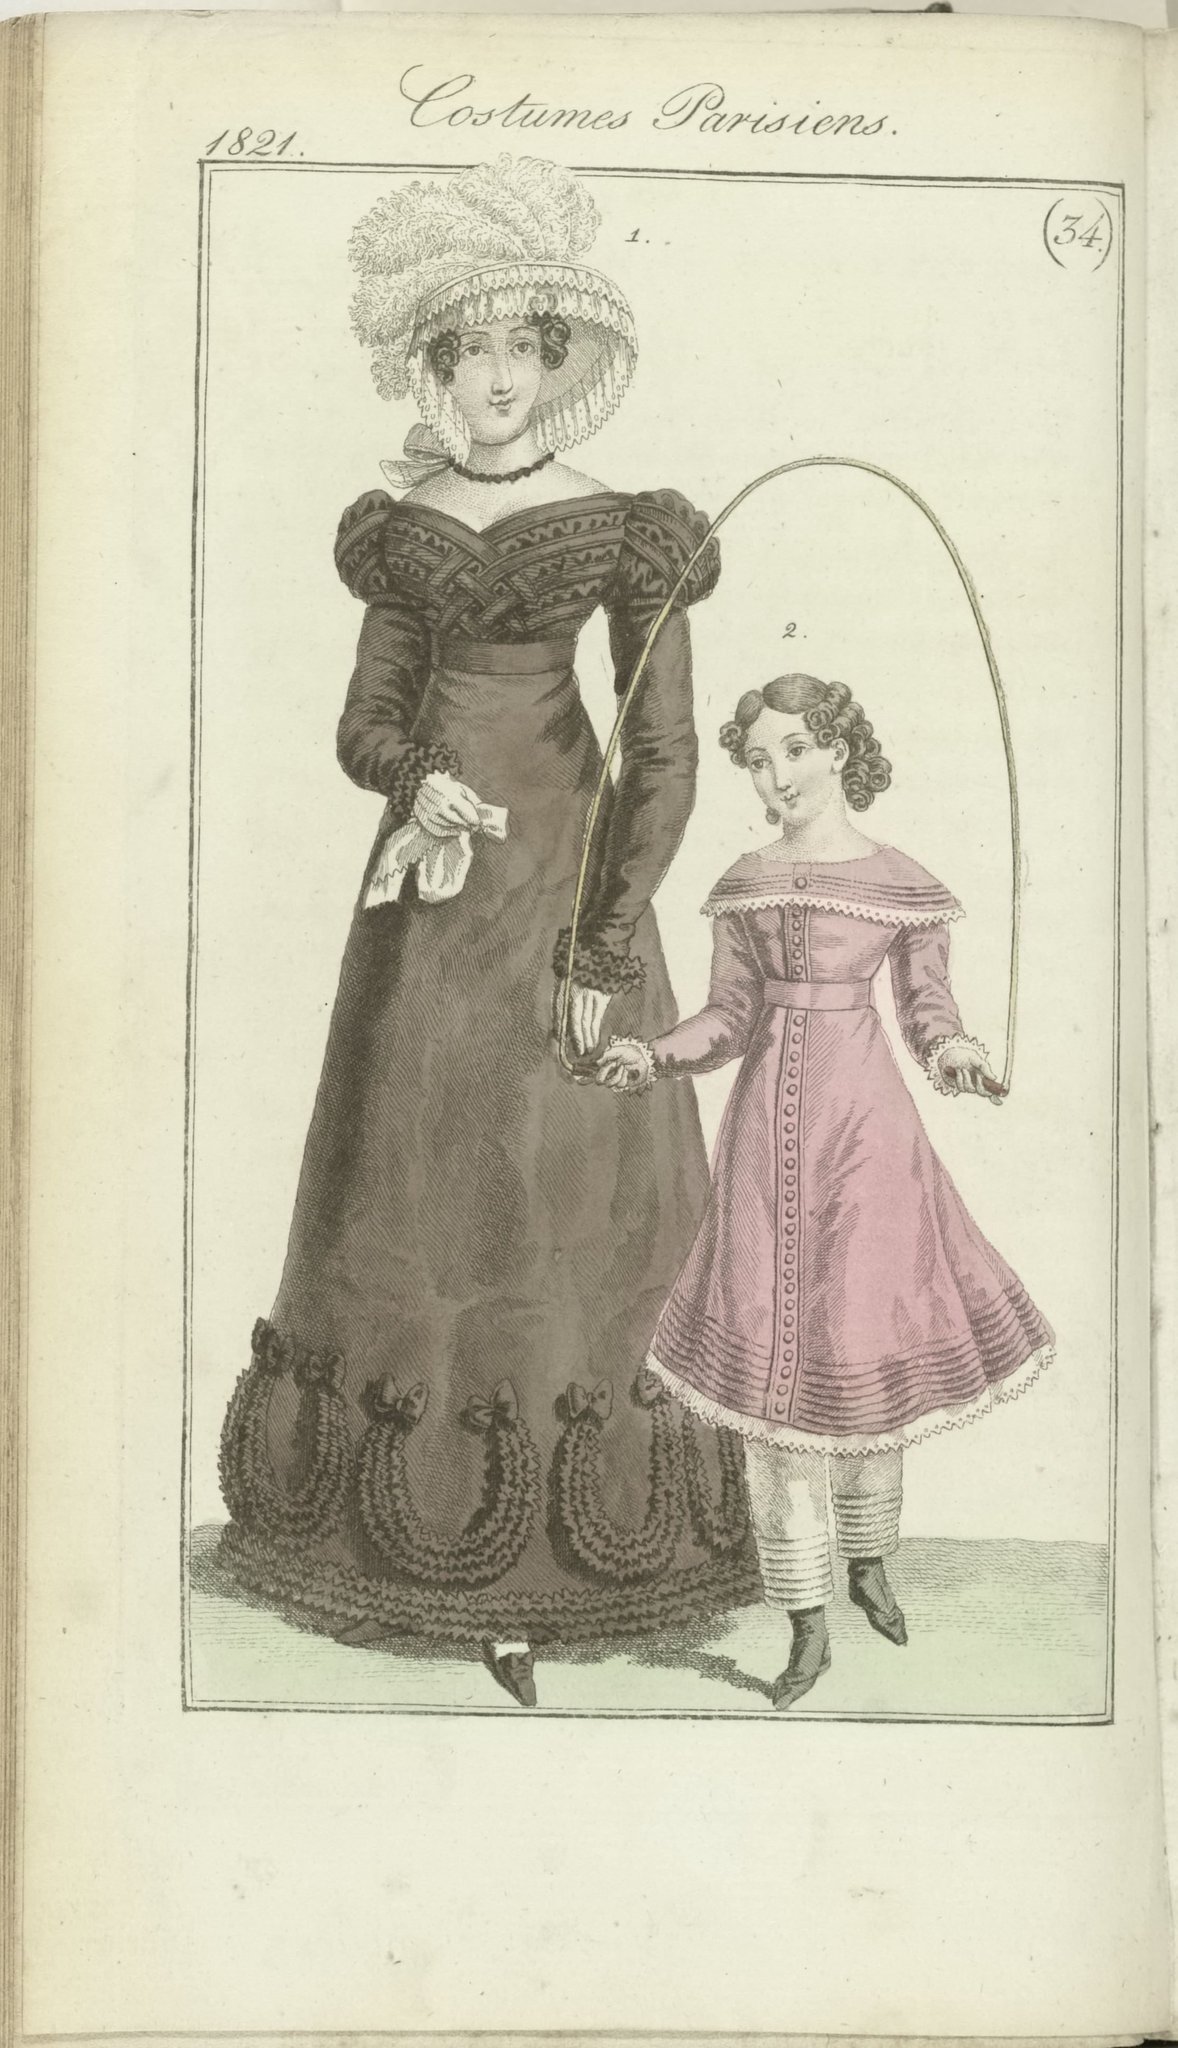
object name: fashion print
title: Journal des Dames et des Modes, editie Frankfurt 19 aout 1821, Costumes Parisiens (34)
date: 1821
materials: paper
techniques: engraving, hand coloring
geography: frankfurt am main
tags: handkerchief (+ women's clothes), lace (+ women's clothes), shoes, sandals (+ girls' clothes), underclothes for the lower part of the body: bloomers (+ girls' clothes), trousers, breeches (+ girls' clothes), clothing for the upper part of the body (mantelet) (+ girls' clothes), styles of hairdress - aa - ~ women, fashion plates, head-gear: hat (+ women's clothes), shoes, sandals (+ women's clothes), gloves, mittens, etc. (+ women's clothes), dress, gown (+ women's clothes), jumping-rope games, dress, gown (+ girls' clothes)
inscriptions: title: ‘Costumes Parisiens.’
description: De begeleidende tekst (p. 224) vermeldt: Fig. 1: Hoed van gaze, versierd met maraboeveren en een dubbele 'blonde'. Japon van gros-de- Naples, waarvan het lijfje uit kruislingse stroken en banden bestaat. De onderrand van de japon is gegarneerd met ruches. Witte handschoenen. Bruine Schoenen. Fig. 2: Kapsel à la Léontine. Japon van linnen met een pelerine, afgezet met zoompjes en een smalle strook tule. Broek van katoenbatist. Schoenen en slobkousen van rode katoenbatist. De prent maakt deel uit van het modetijdschrift Journal des Dames et des Modes, uitgegeven in Frankfurt als kopie van de Franse editie van Pierre de la Mésangère, Parijs, 1797-1839.